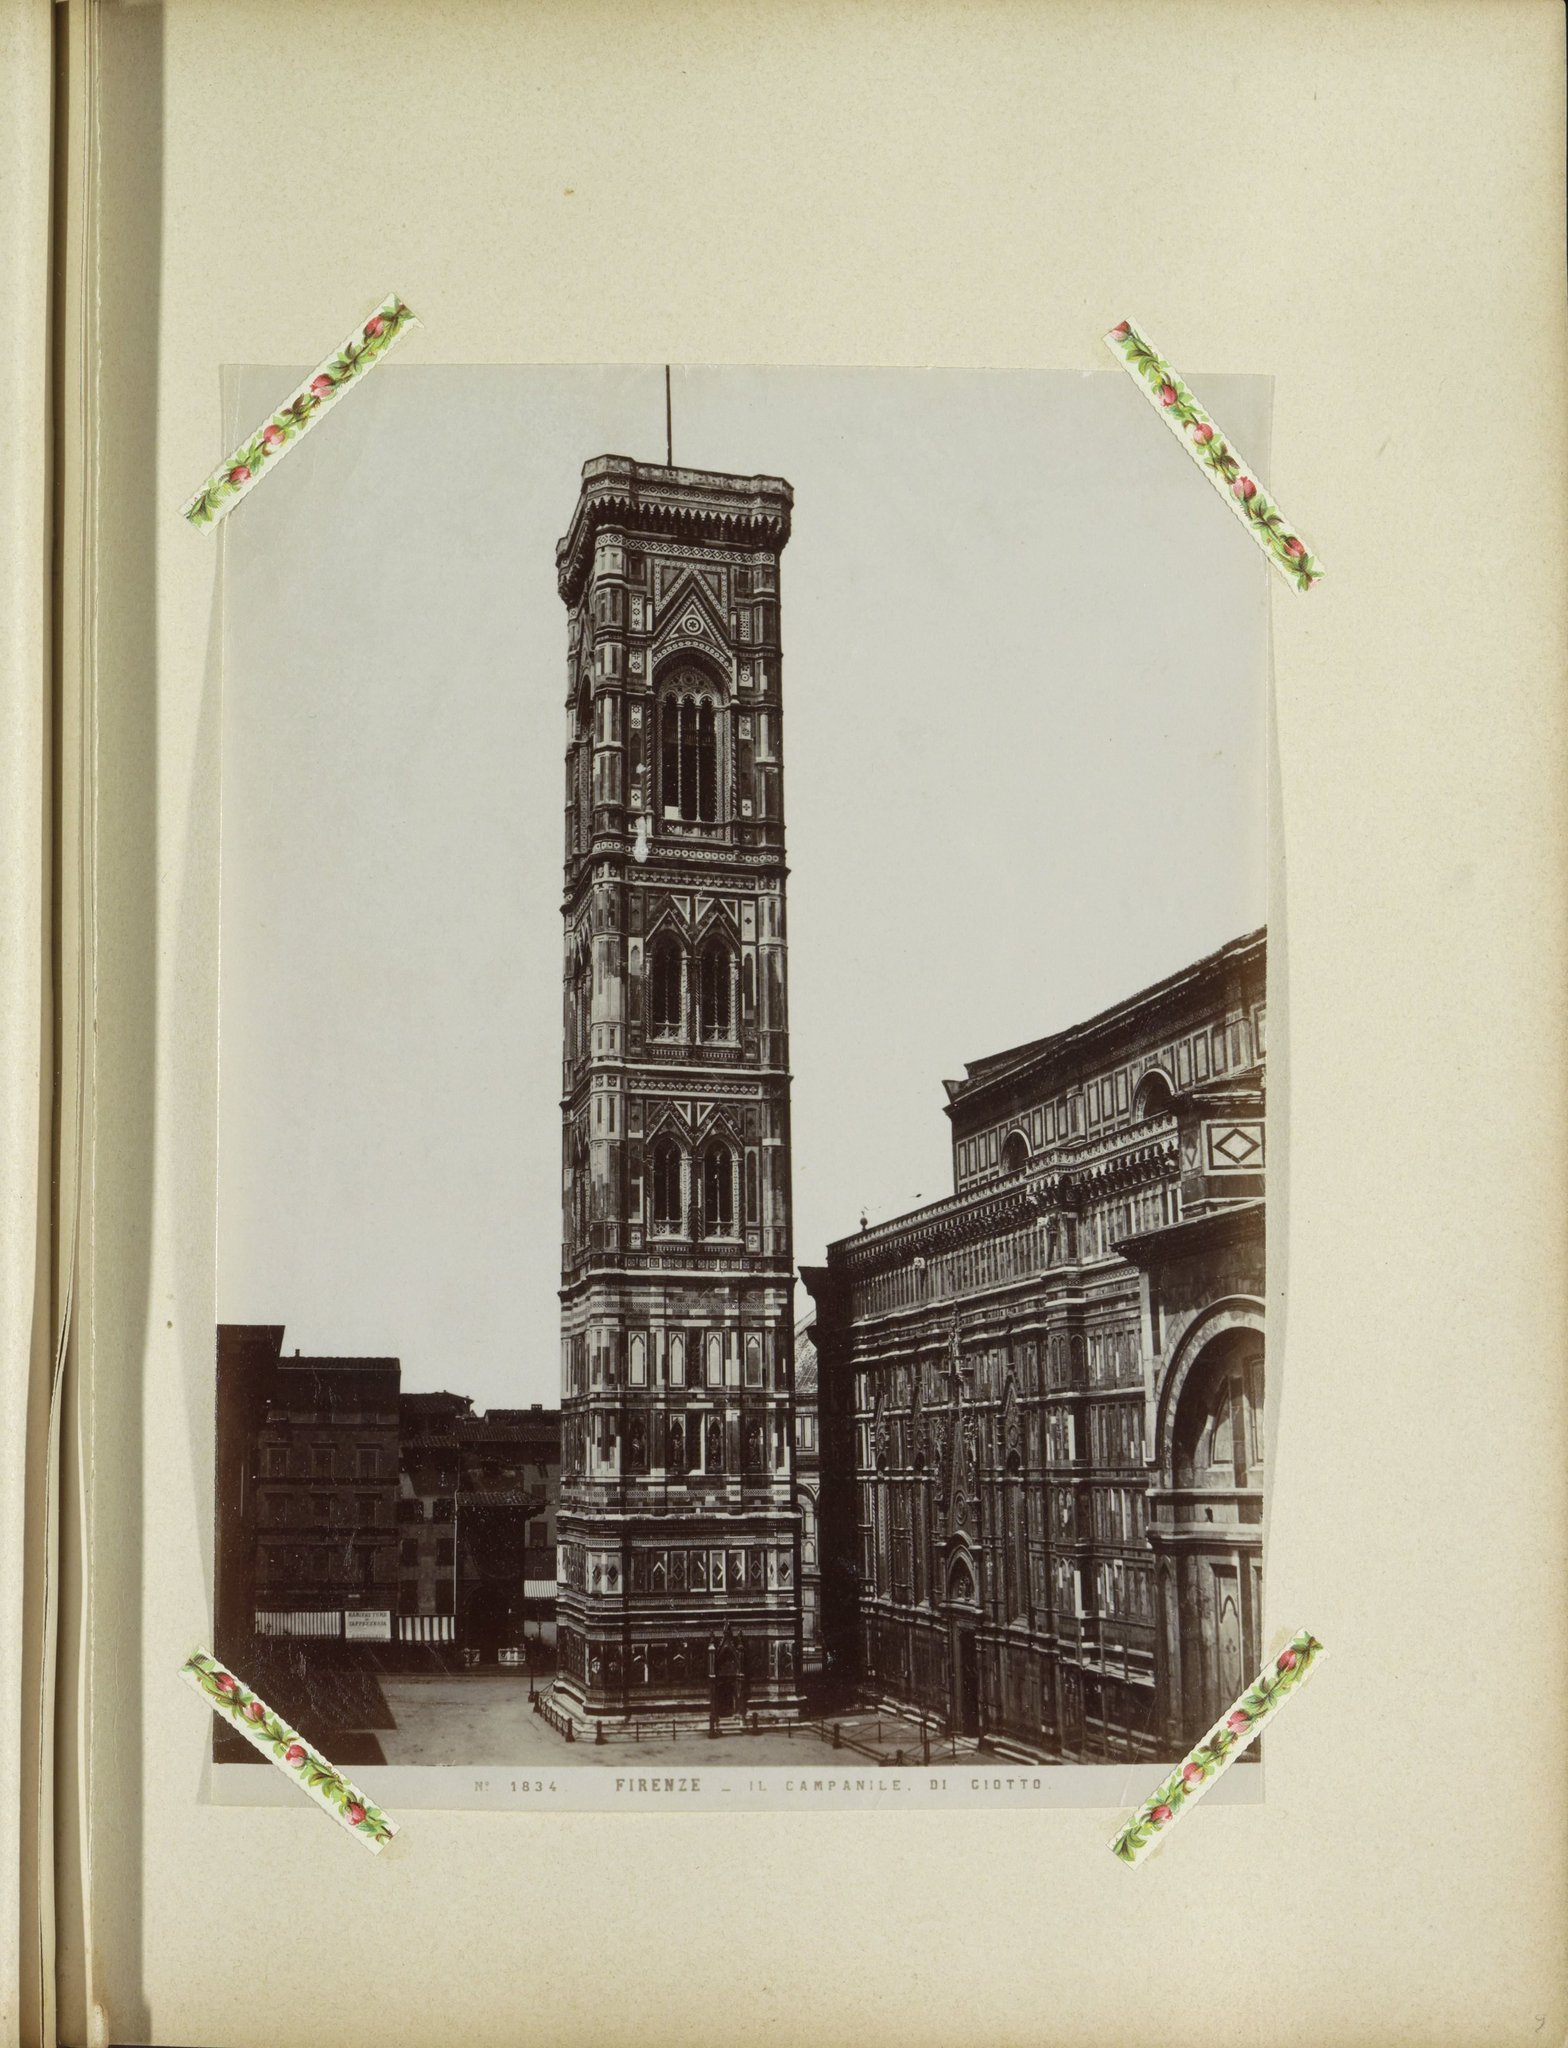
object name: photograph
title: Campanile van de kathedraal van Florence (toren van Giotto)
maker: Anonymous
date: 1860-1900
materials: photographic support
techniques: albumen print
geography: florence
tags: parts of church exterior and annexes: campanile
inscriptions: number: ‘1834’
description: Onderdeel van Fotoalbum met opnames van bezienswaardigheden in Italiaanse steden en van kunstwerken.